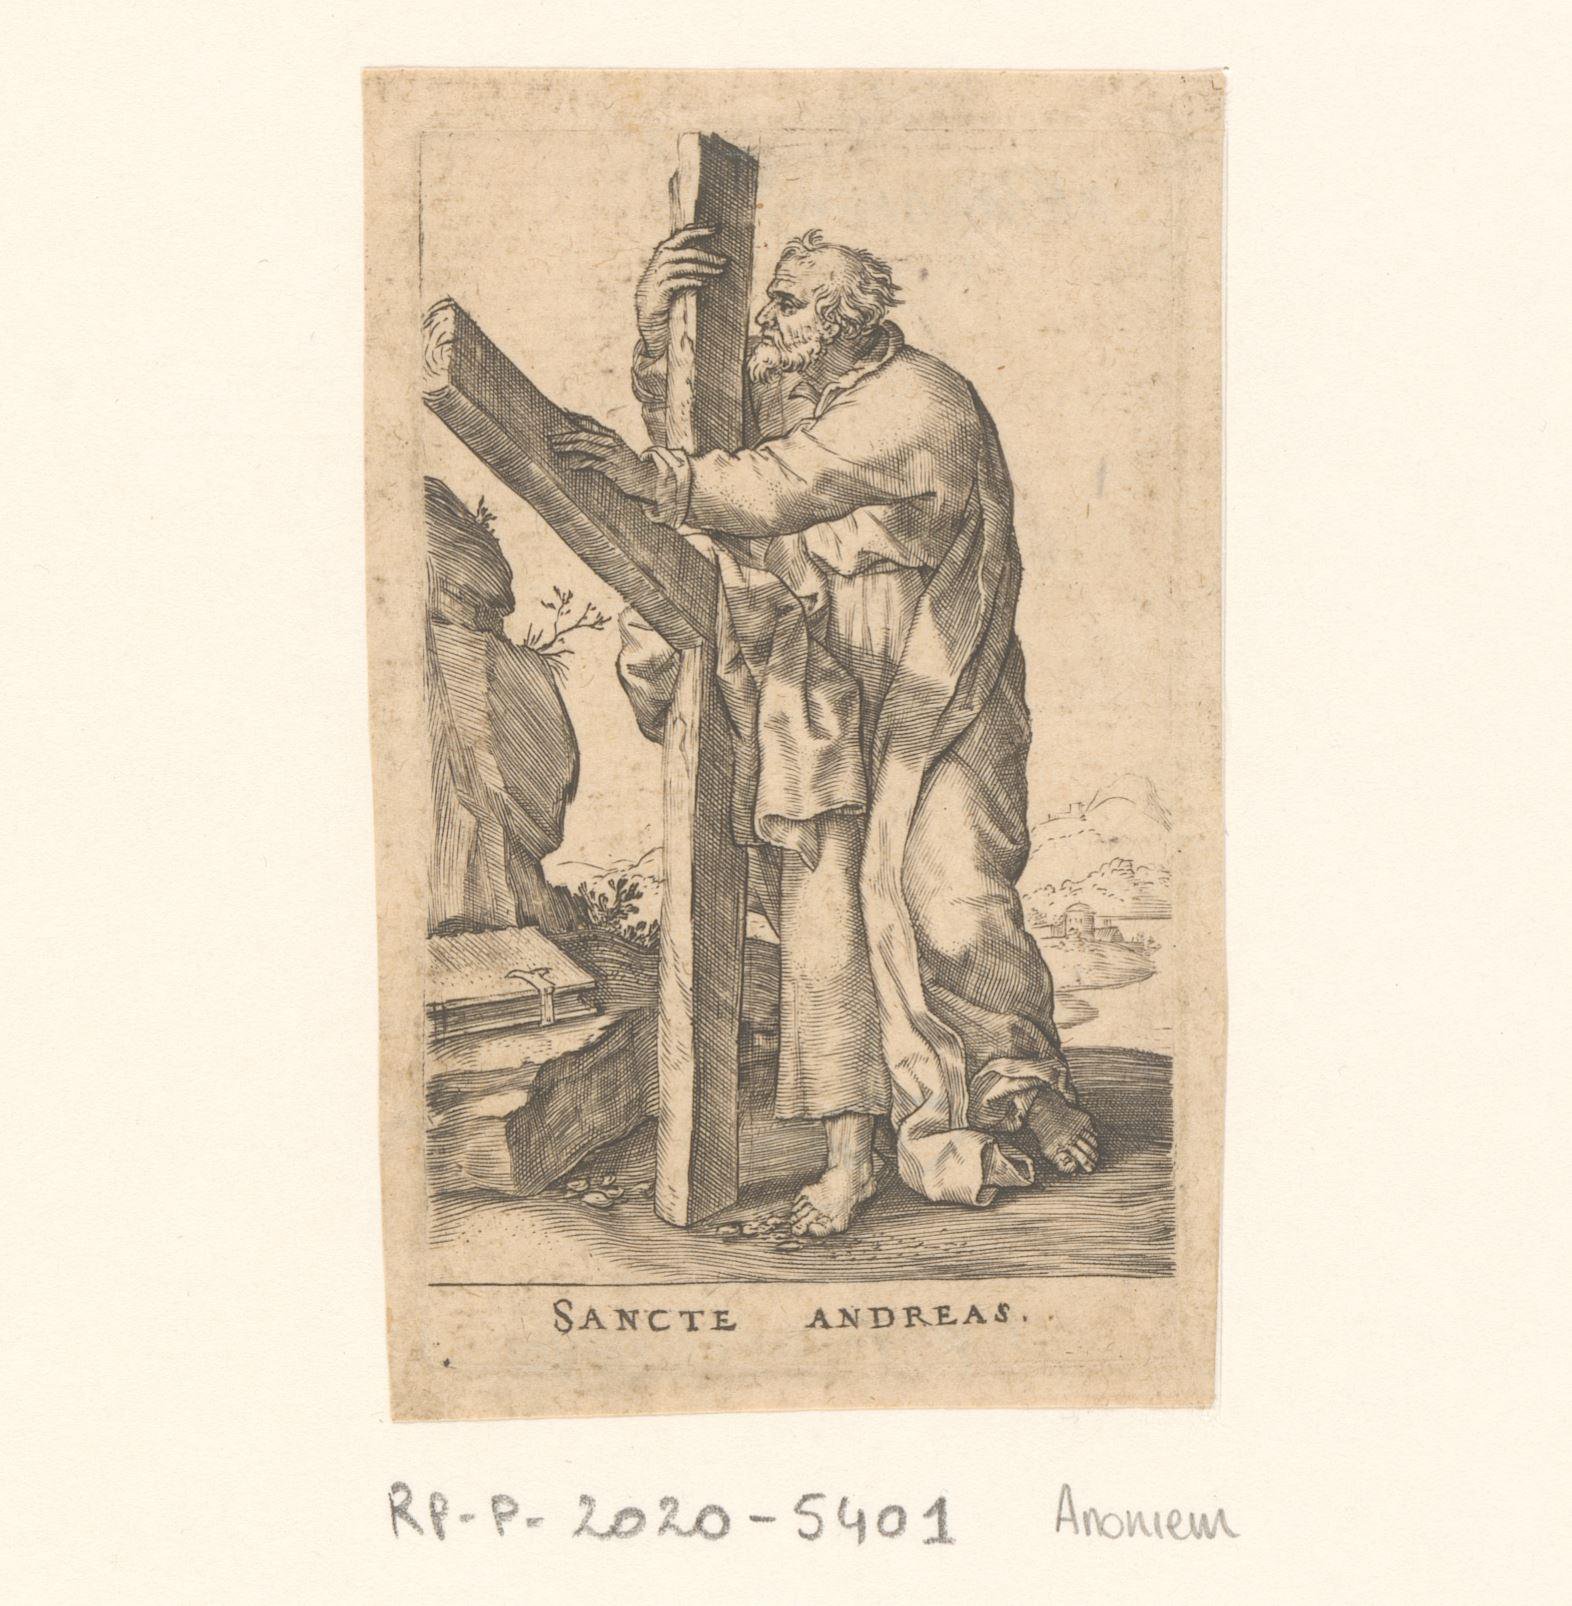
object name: print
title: Sancte Andreas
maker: Anonymous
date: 1550-1600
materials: paper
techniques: engraving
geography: southern netherlands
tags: the apostle andrew; possible attributes: book, x-shaped cross, fish, fishing-net, rope, scroll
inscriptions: collector's mark: Lugt 2228